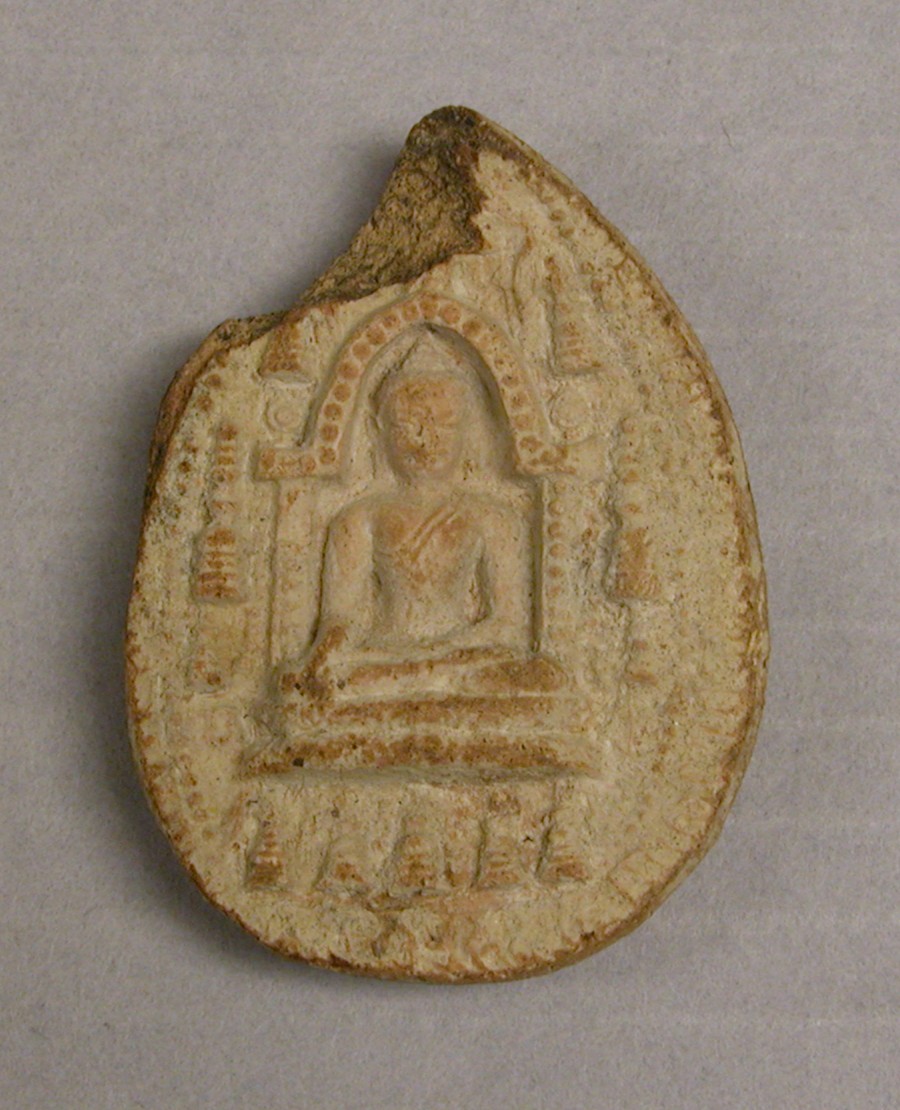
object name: votive plaque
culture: indian or thai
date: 1001-1200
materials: terracotta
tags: buddhism,buddha,stupas